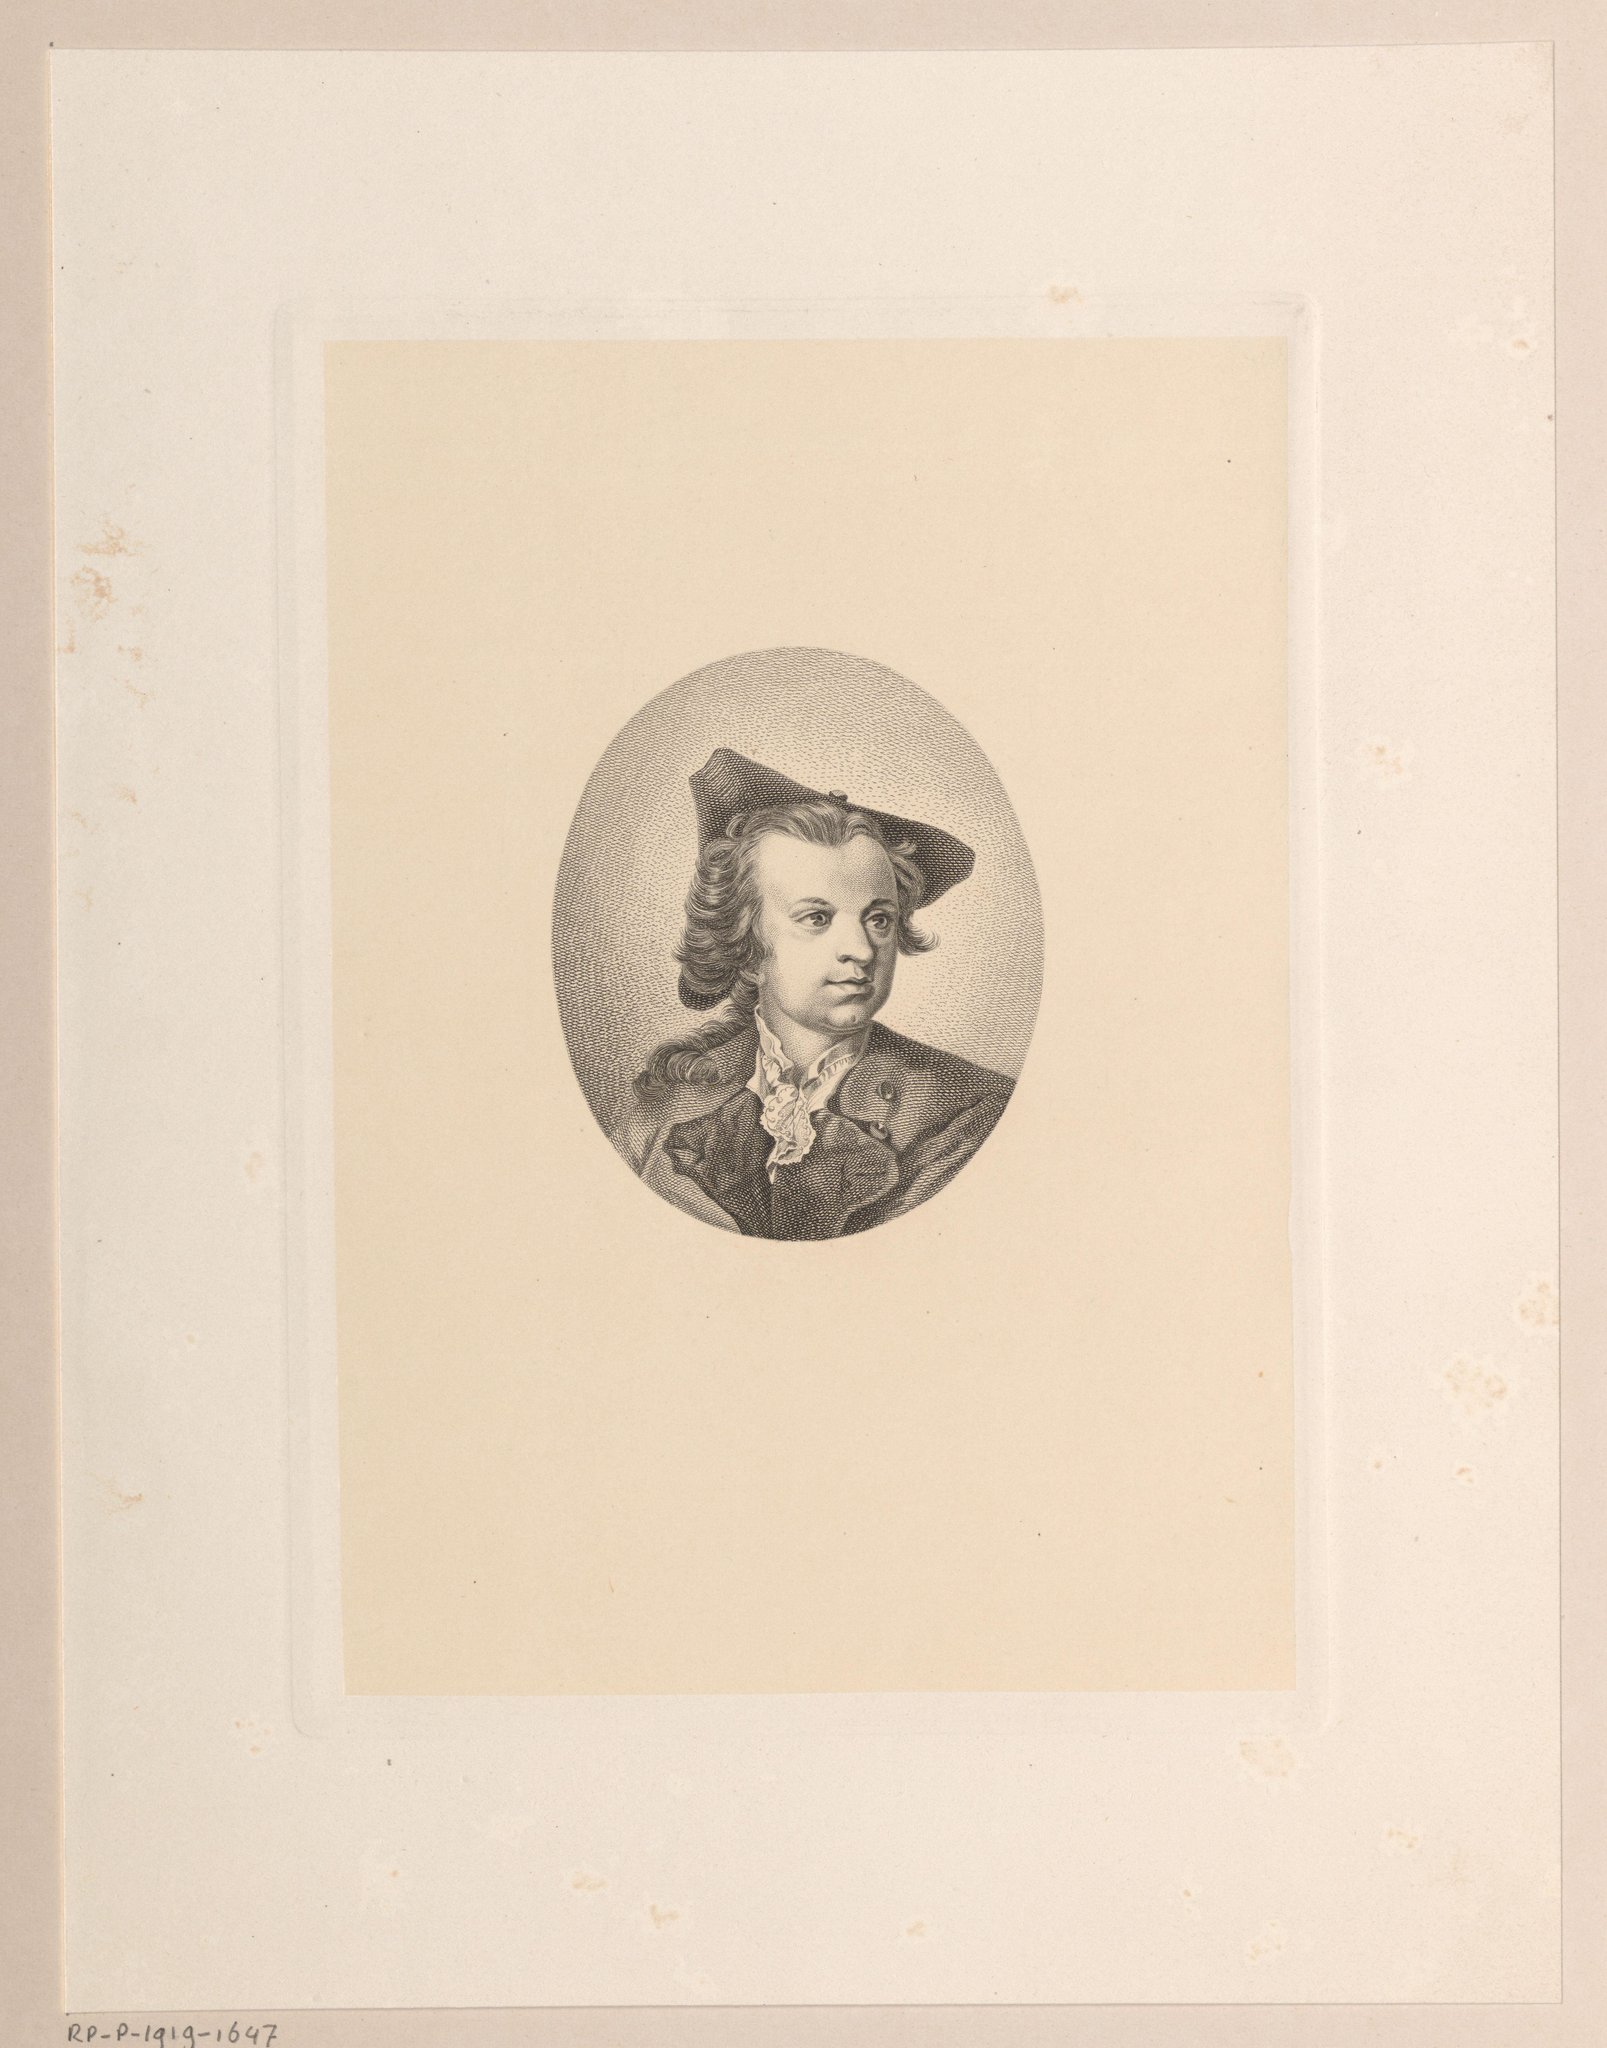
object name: print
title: Portret van een onbekende jongen, mogelijk Friedrich von Schiller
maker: Anonymous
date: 1800-1899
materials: paper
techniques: engraving, etching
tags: boy (child between toddler and youth), anonymous historical person portrayed alone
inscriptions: collector's mark: Lugt 2228